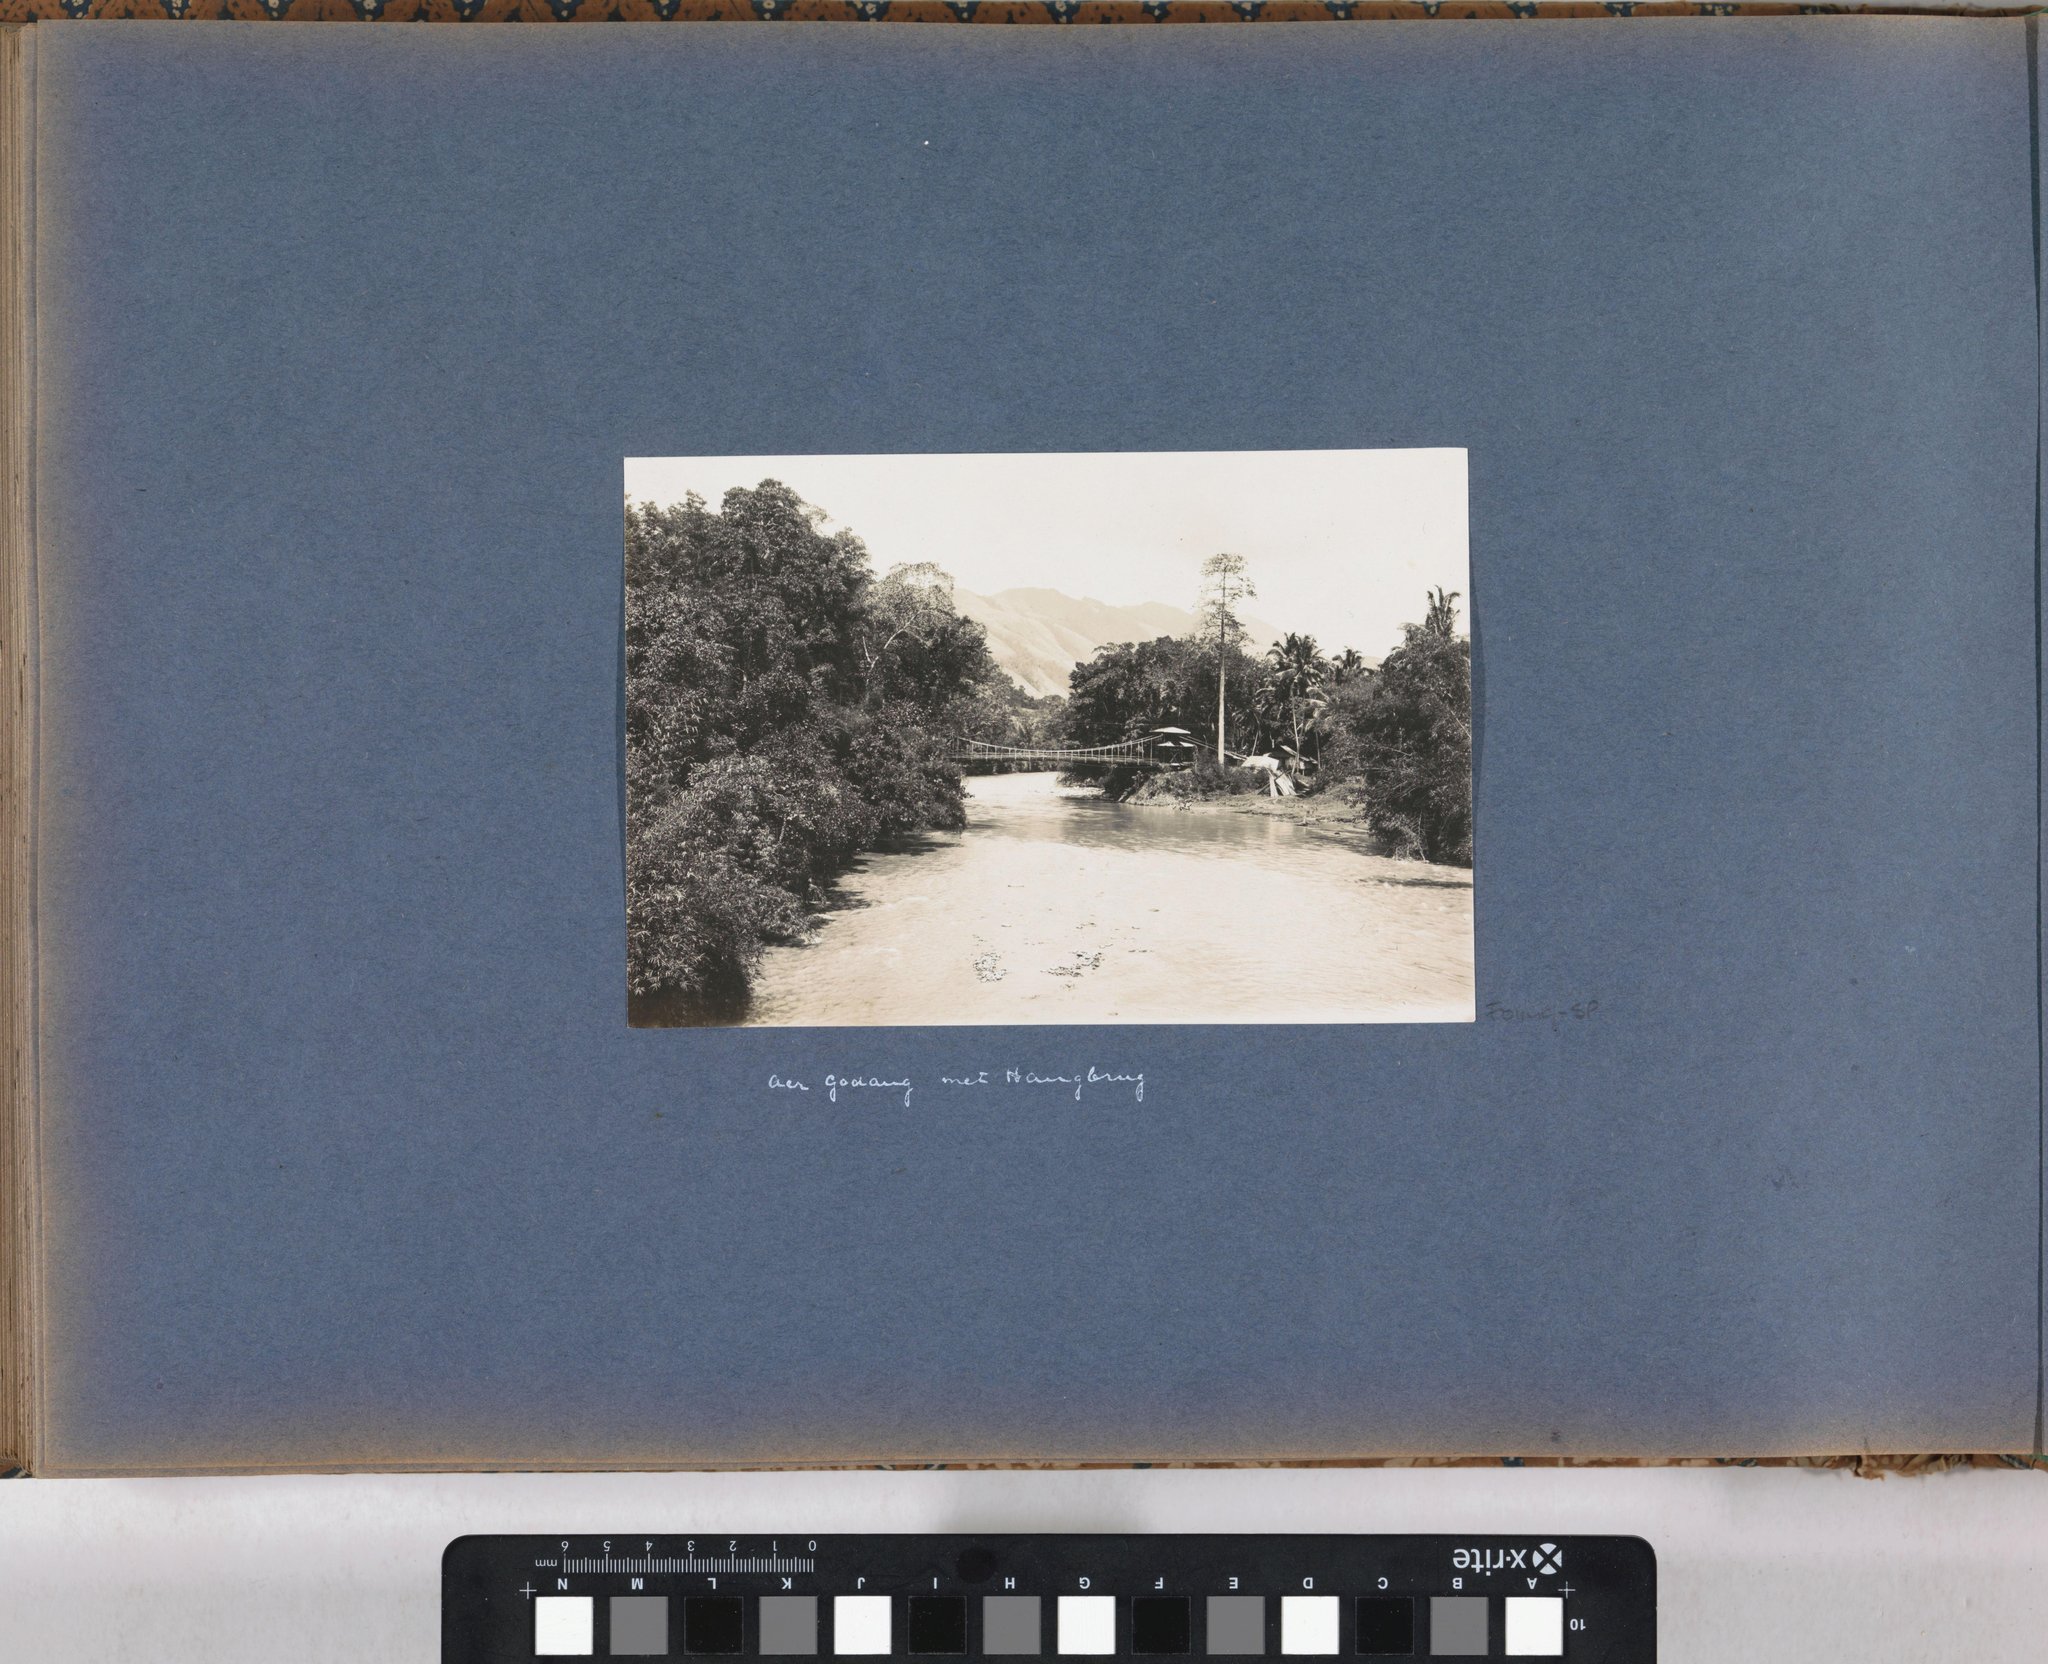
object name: album leaf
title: Hangbrug over een rivier in Aek Godang op Sumatra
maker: Anonymous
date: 1900-1920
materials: paper, photographic support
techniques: gelatin silver print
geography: sumatra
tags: suspension bridge, river (+ landscape with figures, staffage), sumatra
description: Onderdeel van reisalbum met foto's van bedrijvigheid en bezienswaardigheden op Sumatra en Java en van de reis naar en van Nederlands-Indië.